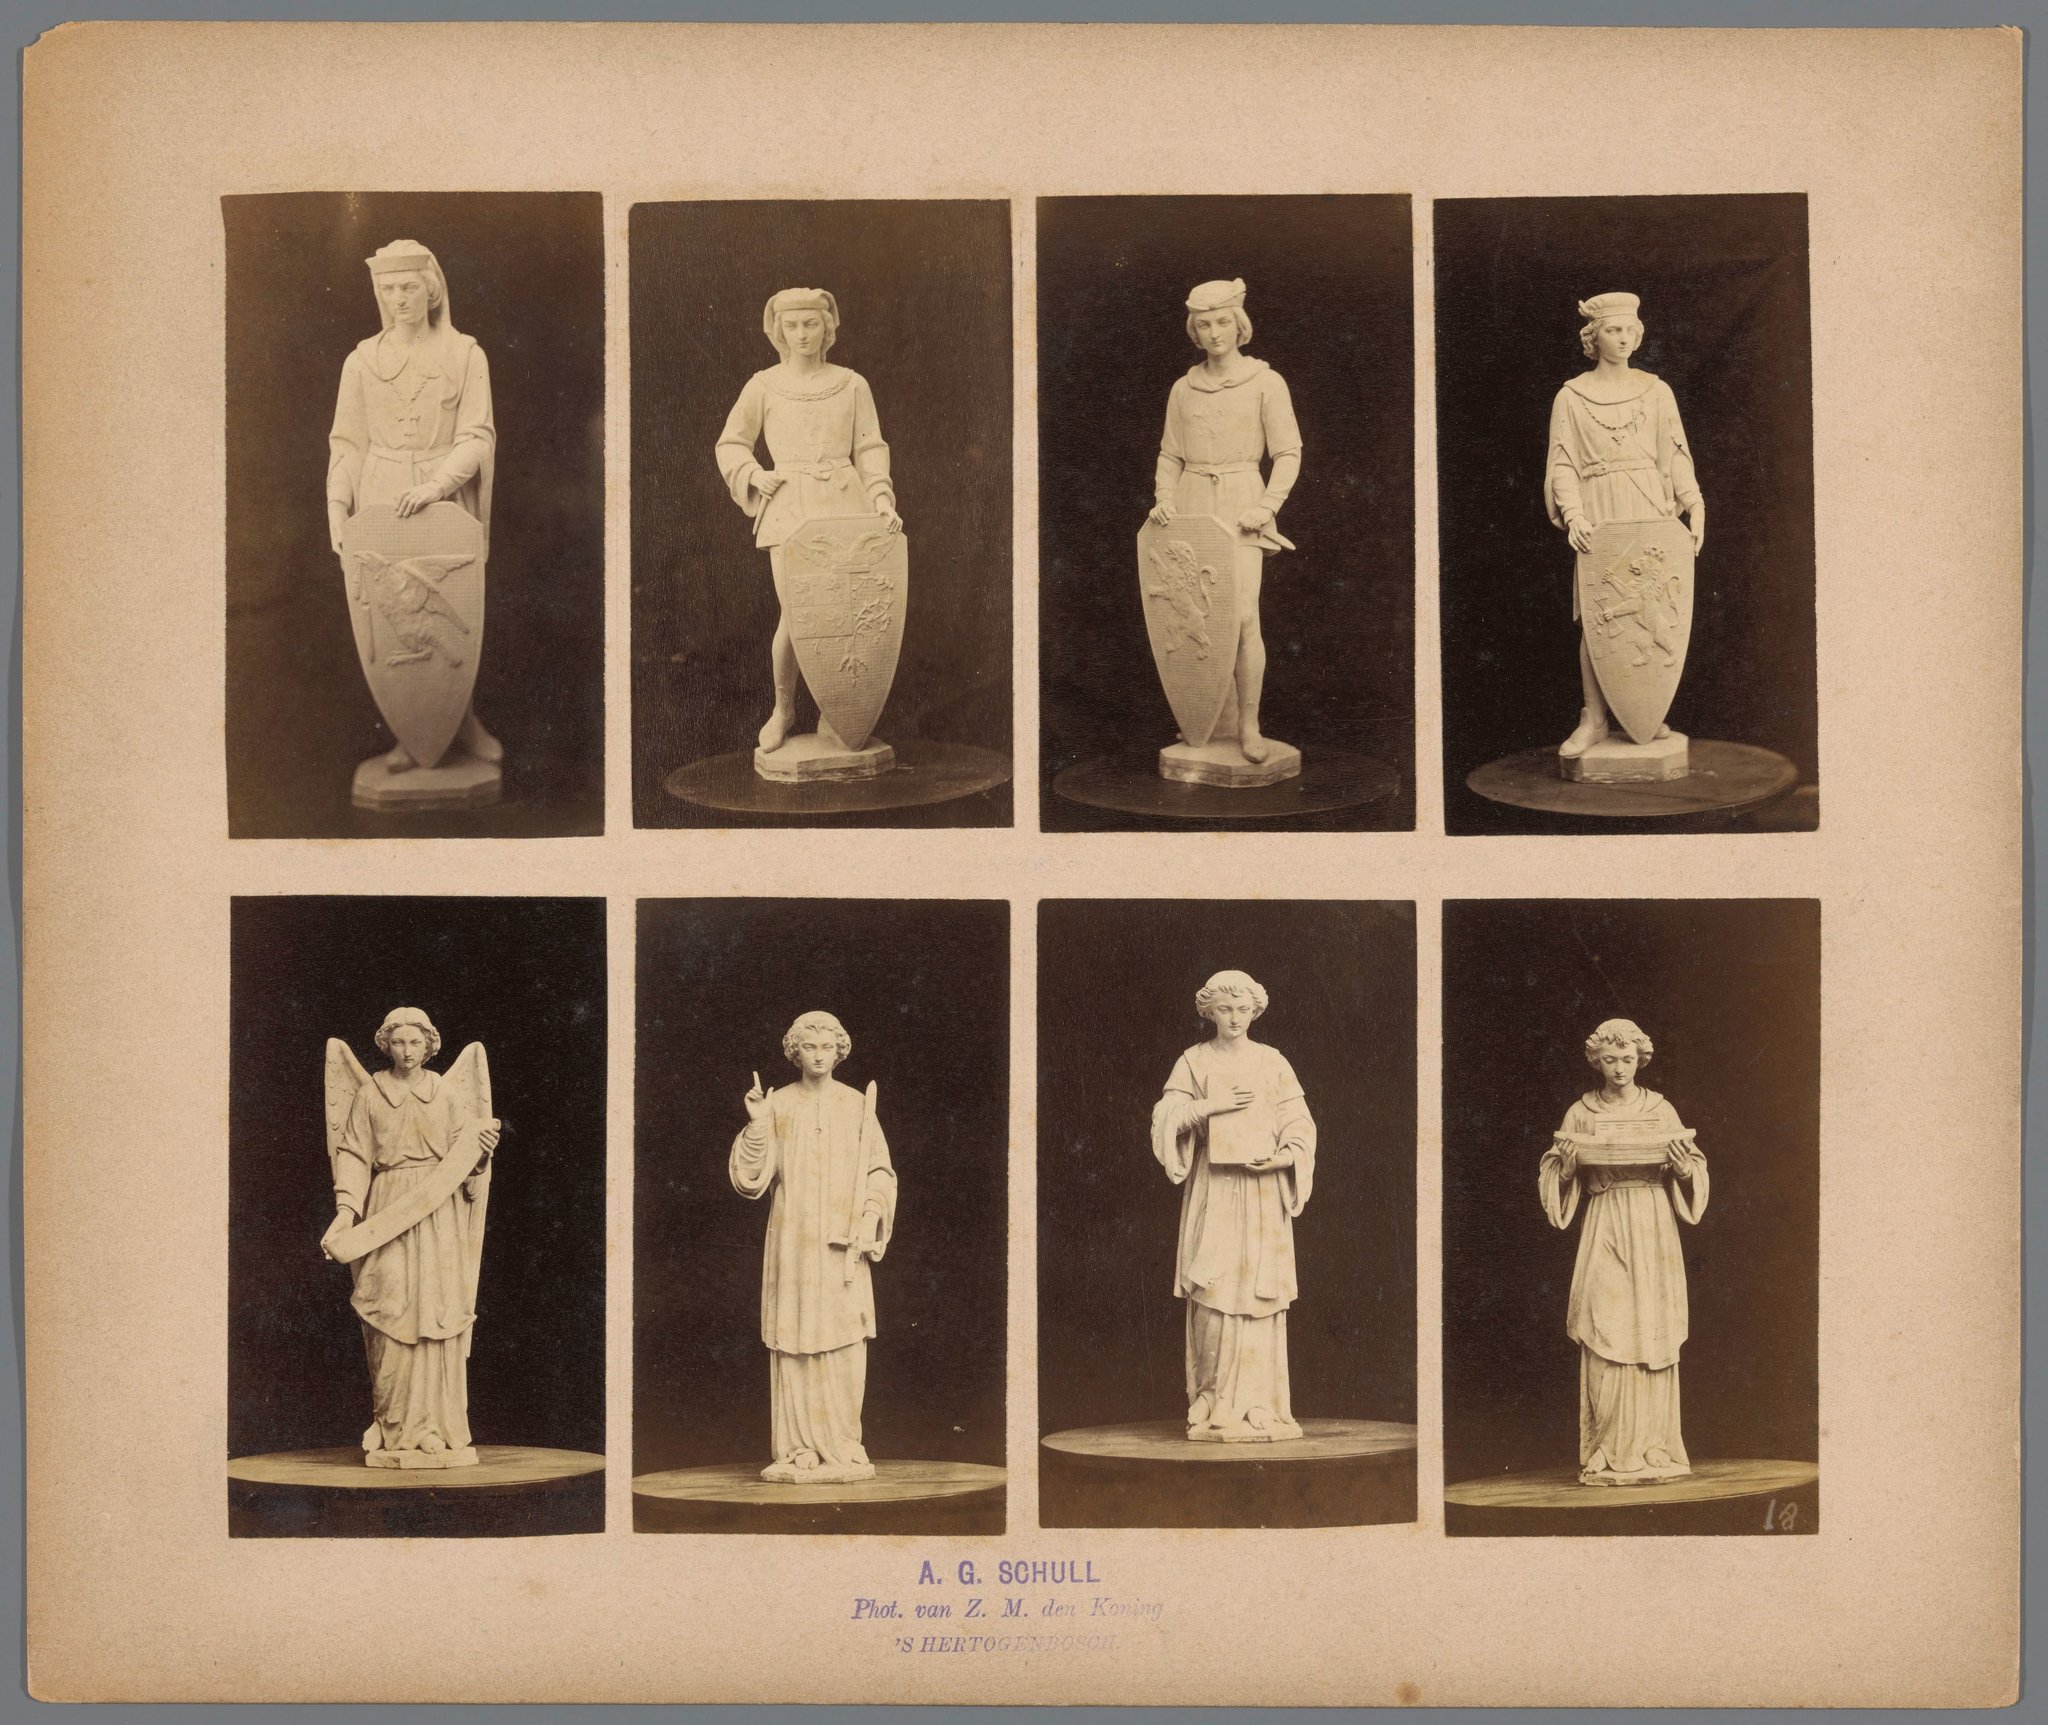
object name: photograph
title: Overzicht van acht sculpturen van jongemannen met voorwerpen in hun hand en een engel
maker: antonius godefridus schull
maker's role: fotograaf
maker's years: 1819-1896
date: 1875-1900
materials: cardboard, photographic support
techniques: albumen print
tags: the ark ~ story of noah, shield-bearer, squire, hacking and thrusting weapons: sword, sculpture, angels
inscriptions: number: ‘18’, name: ‘A. G. SCHULL Phot. van Z. M. den Koning 'S HERTOGENBOSCH’, name: ‘S. FRANCO, b.i. den Haag.’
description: De bovenste rij toont vier jongemannen met wapenschilden, de onderste rij toont links een engel, linksmidden een jongeman met zwaard, rechtsmidden een jongeman met een boek en rechts een jongeman met een model van de ark.